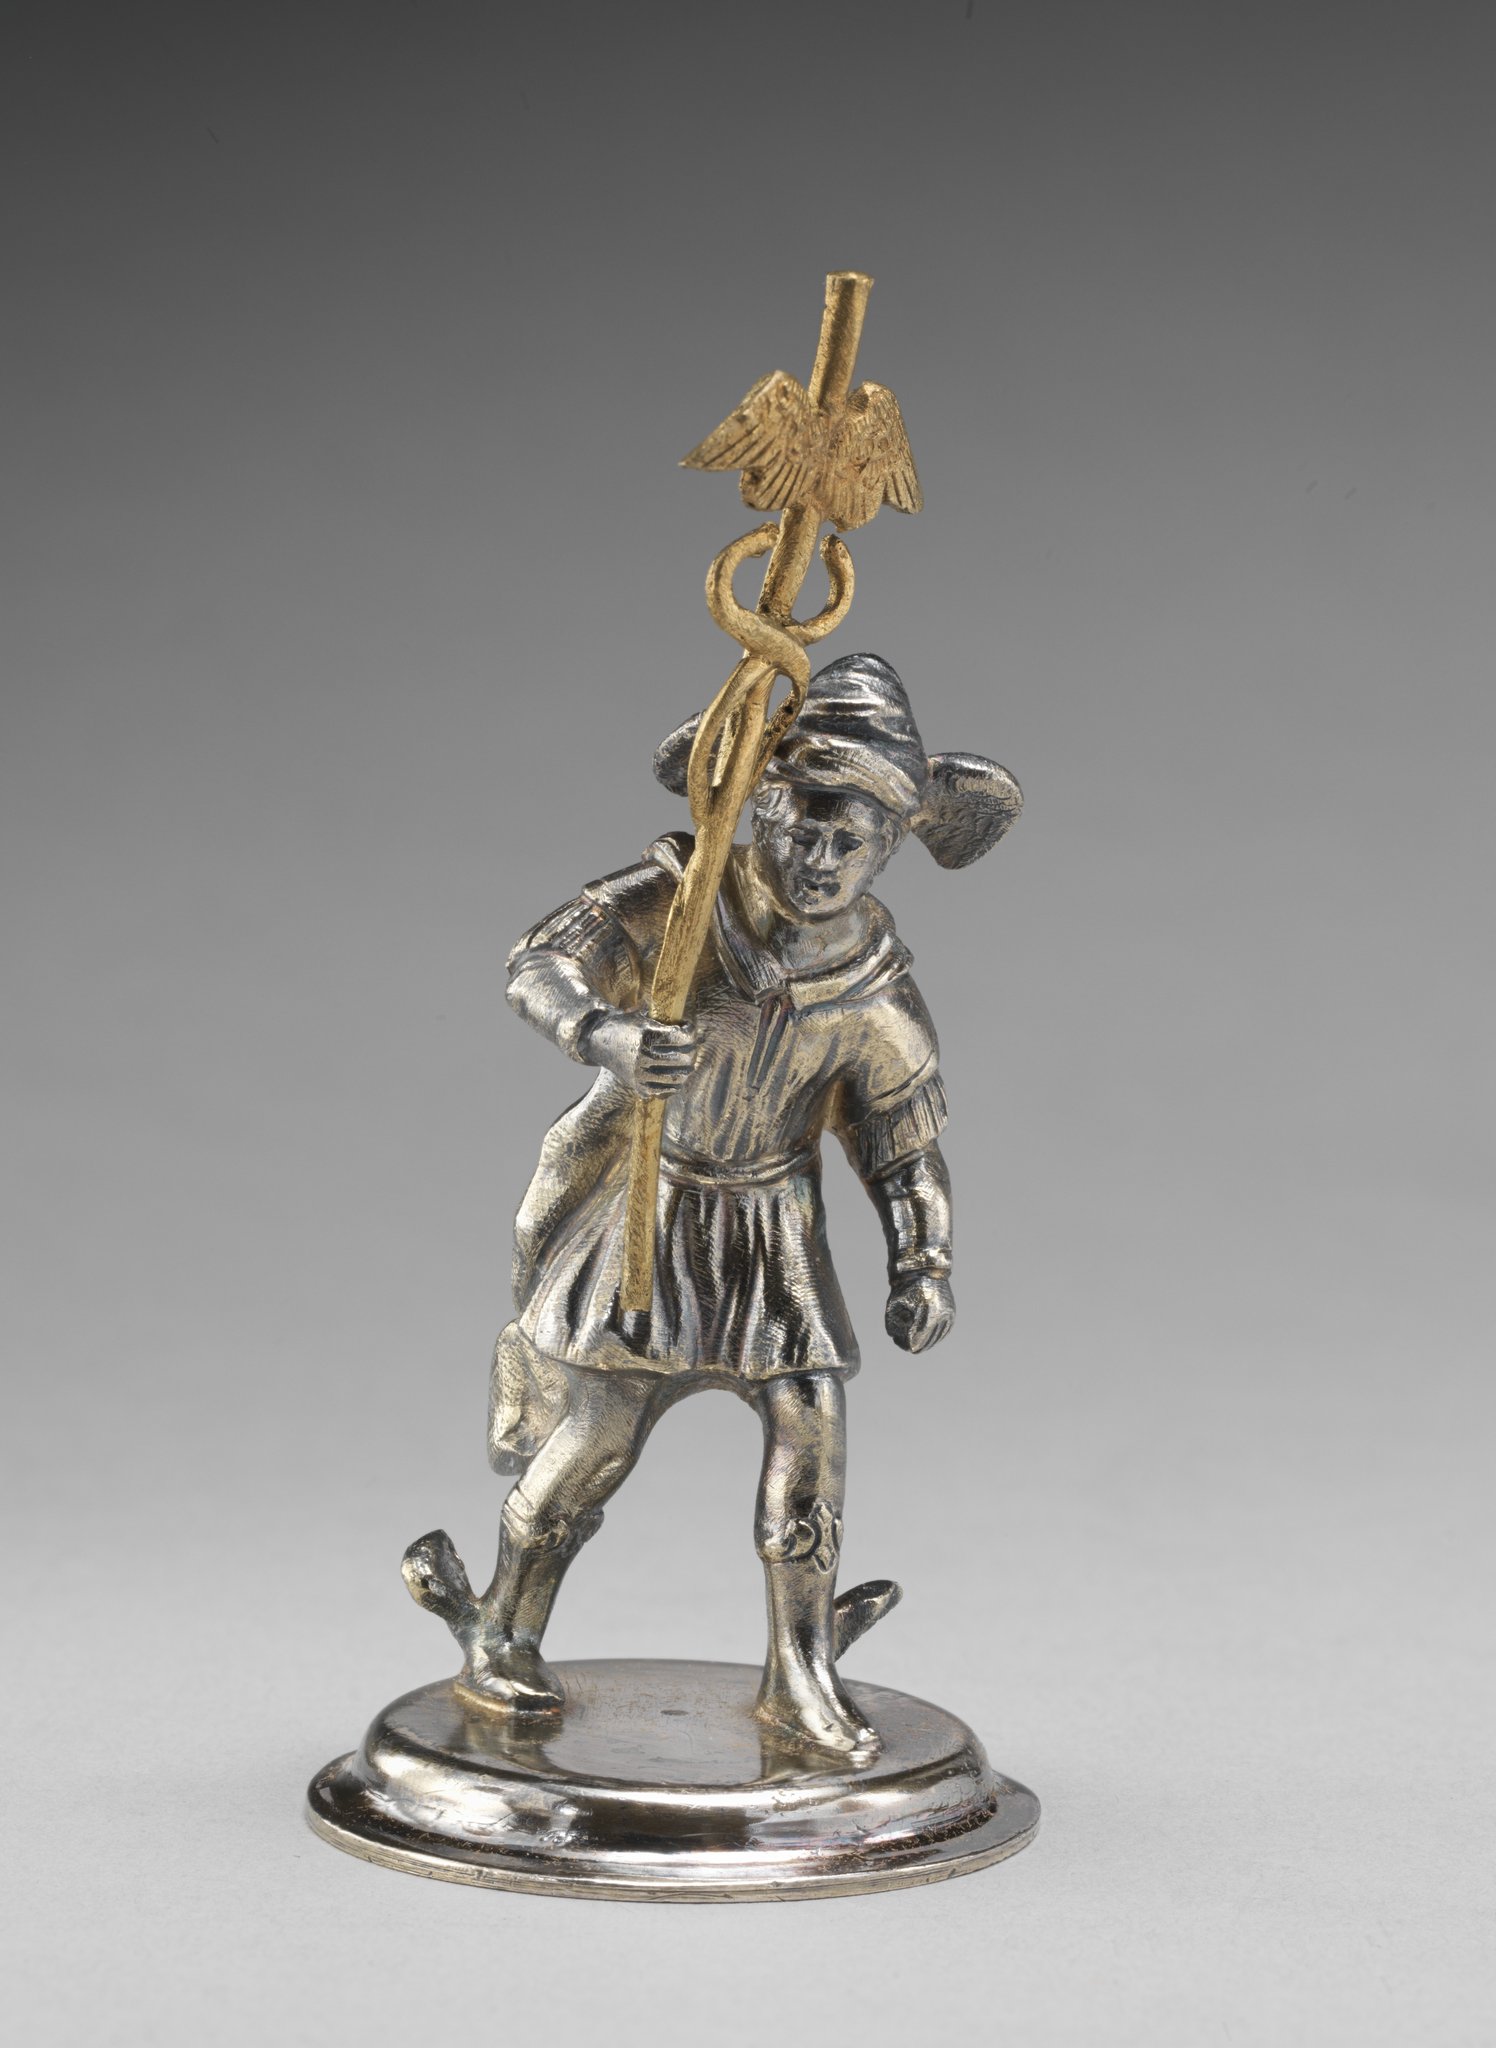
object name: chessman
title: Chessman (Bishop)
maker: elkington & co.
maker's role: manufacturer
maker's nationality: british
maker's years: 1829-1963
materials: silver gilt